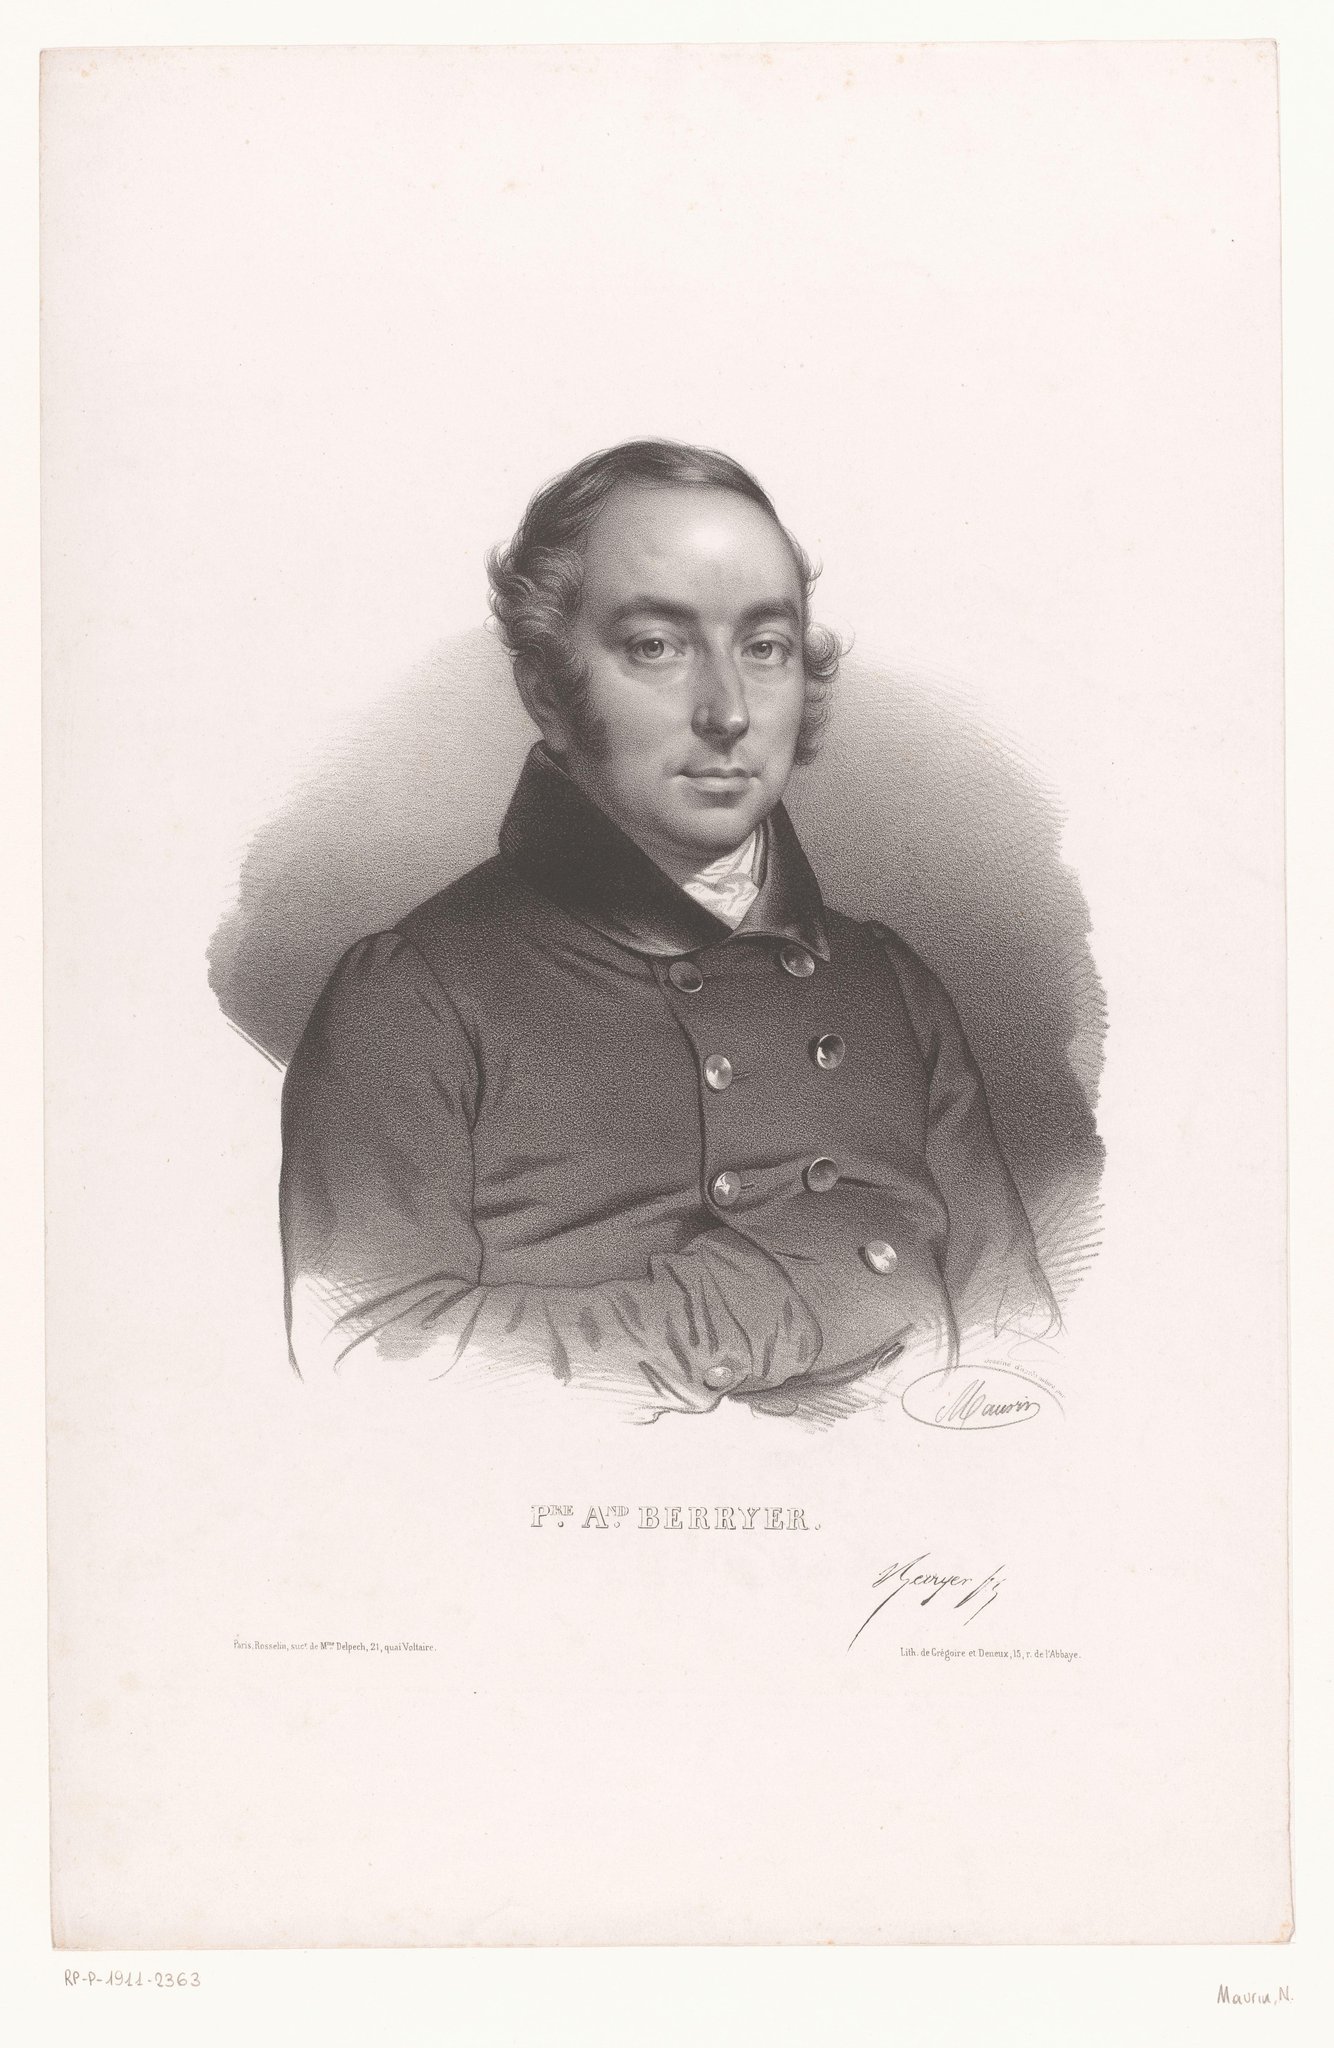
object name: print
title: Pre. And. Berryer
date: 1835-1861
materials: paper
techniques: lithograph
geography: paris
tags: politician, pierre-antoine berryer, historical persons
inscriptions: collector's mark: Lugt 2228